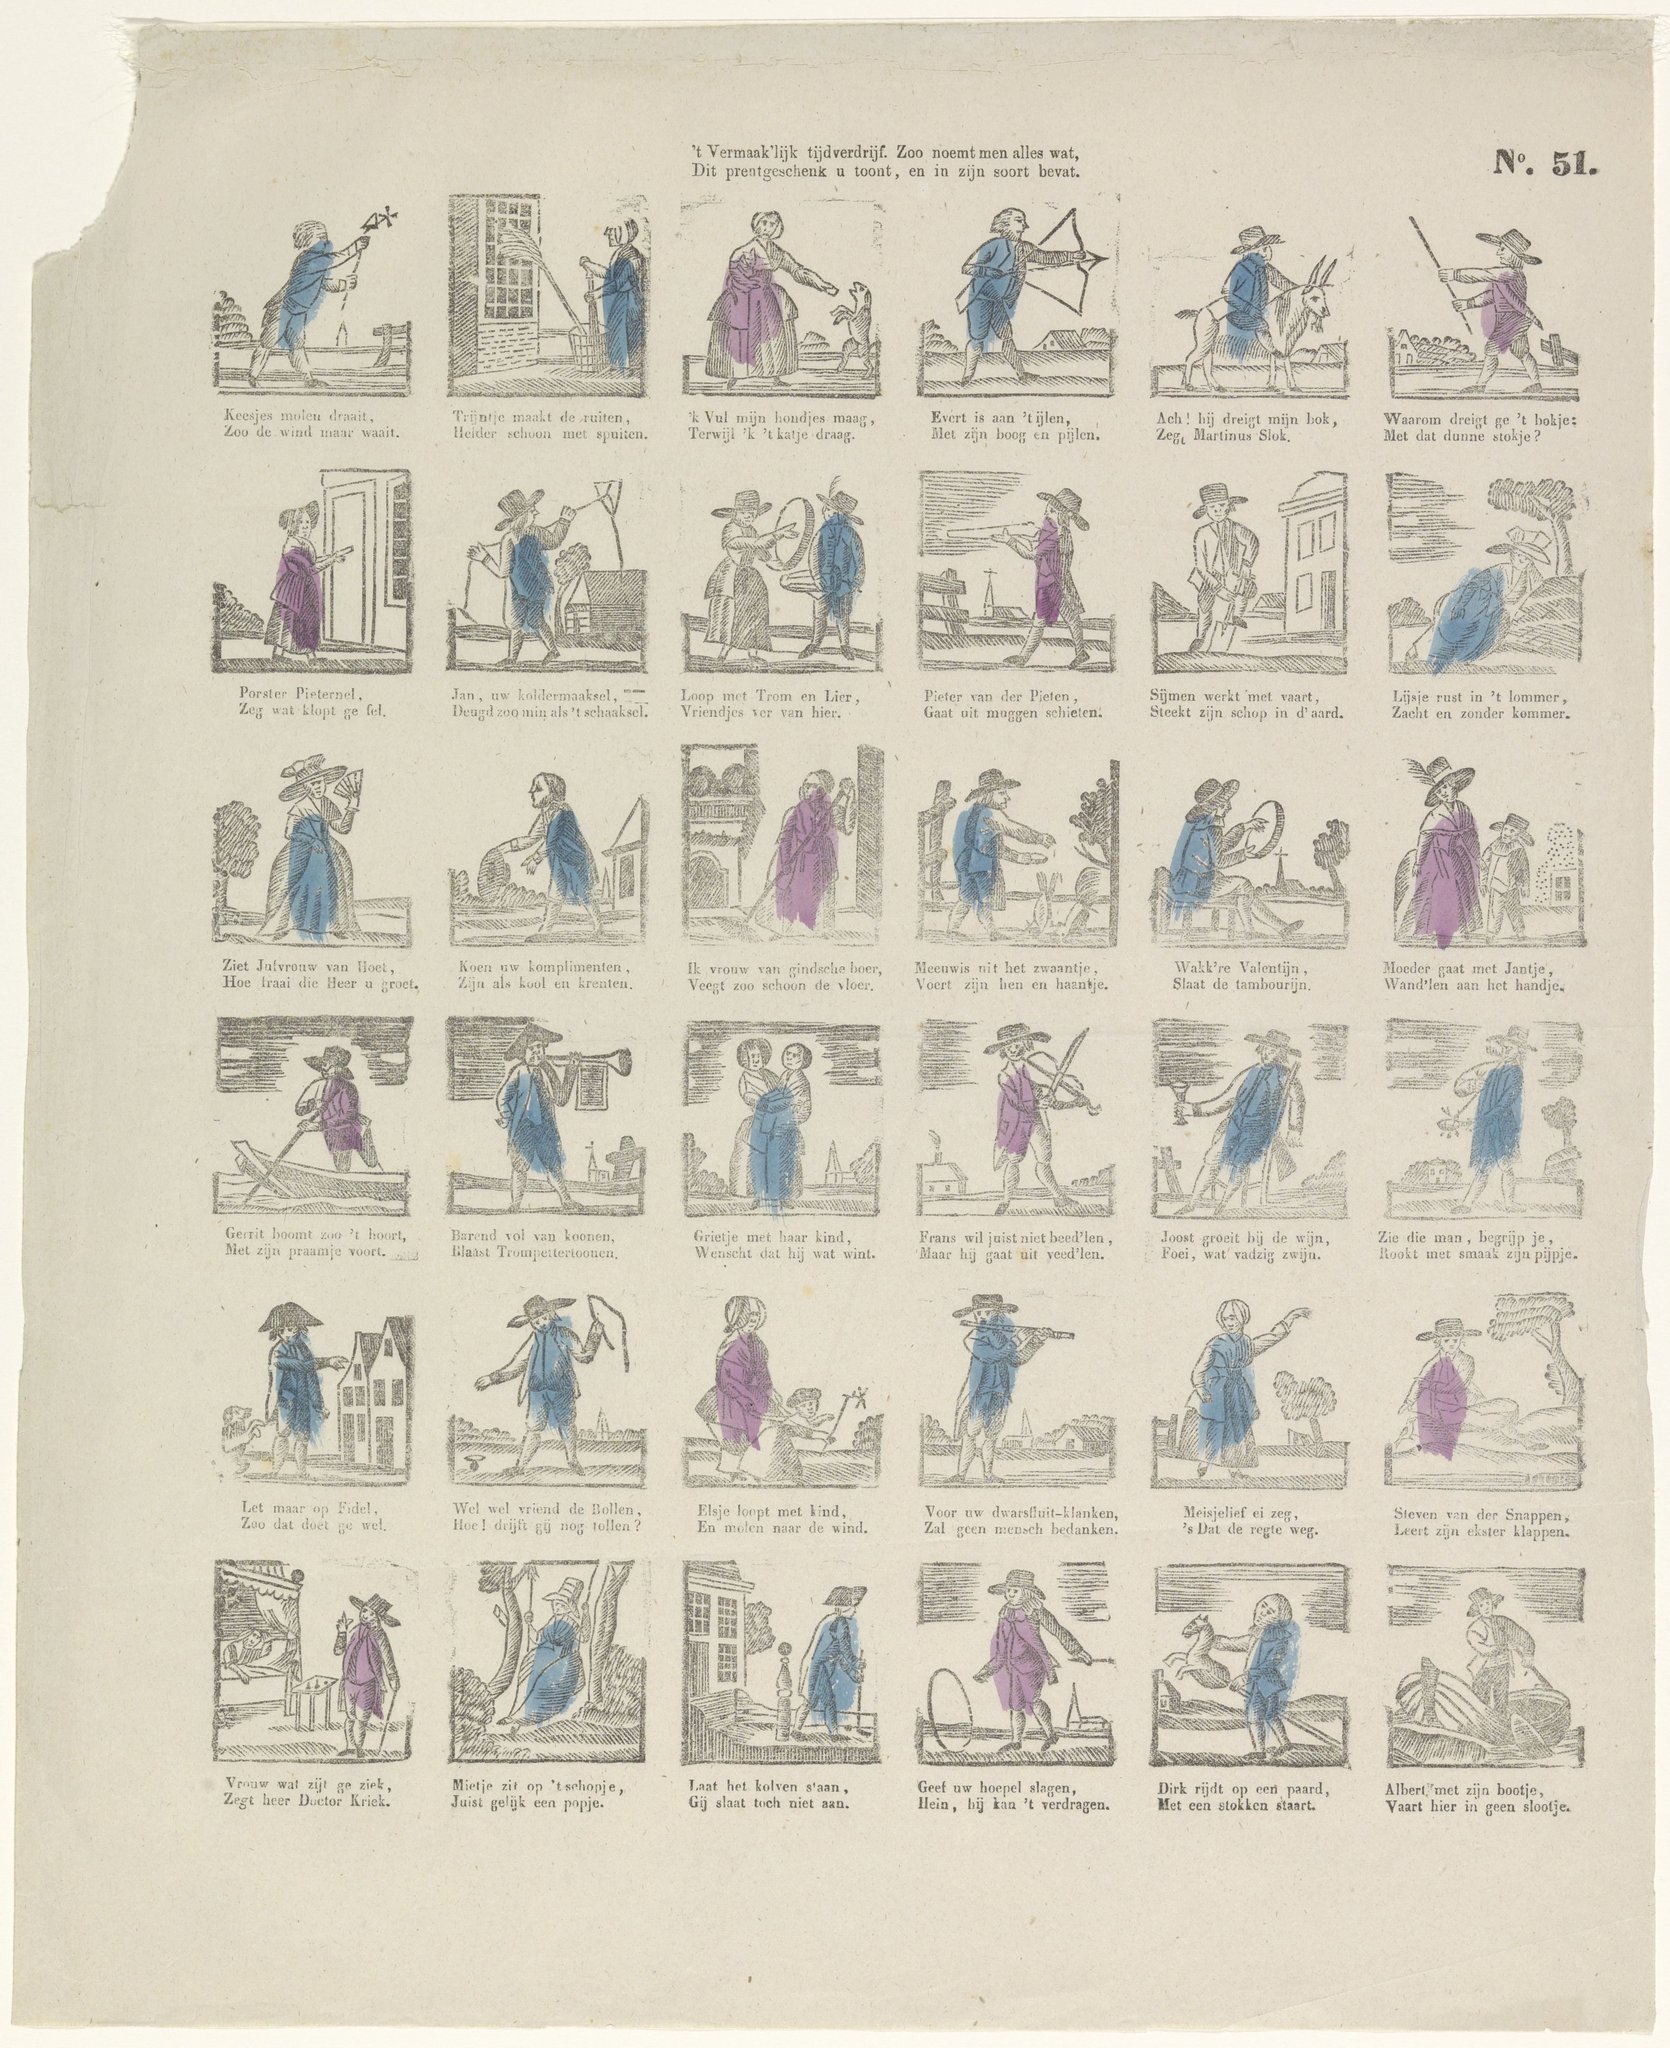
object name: print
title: 'T vermaaklijk tijdverdrijf. Zoo noemt men alles wat. / Dit prentgeschenk u toont, en in zijn soort bevat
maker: monogrammist lub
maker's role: print maker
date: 1850-1870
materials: paper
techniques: colour, letterpress printing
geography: netherlands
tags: musician at work, children's games and plays, games using special objects (marbles, top, hoop, etc.)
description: Blad met 36 voorstellingen van verschillende bezigheden, zoals boogschieten, vliegeren, trompet spelen en hoepelen. Onder elke afbeelding een onderschrift. Genummerd rechtsboven: No. 51.